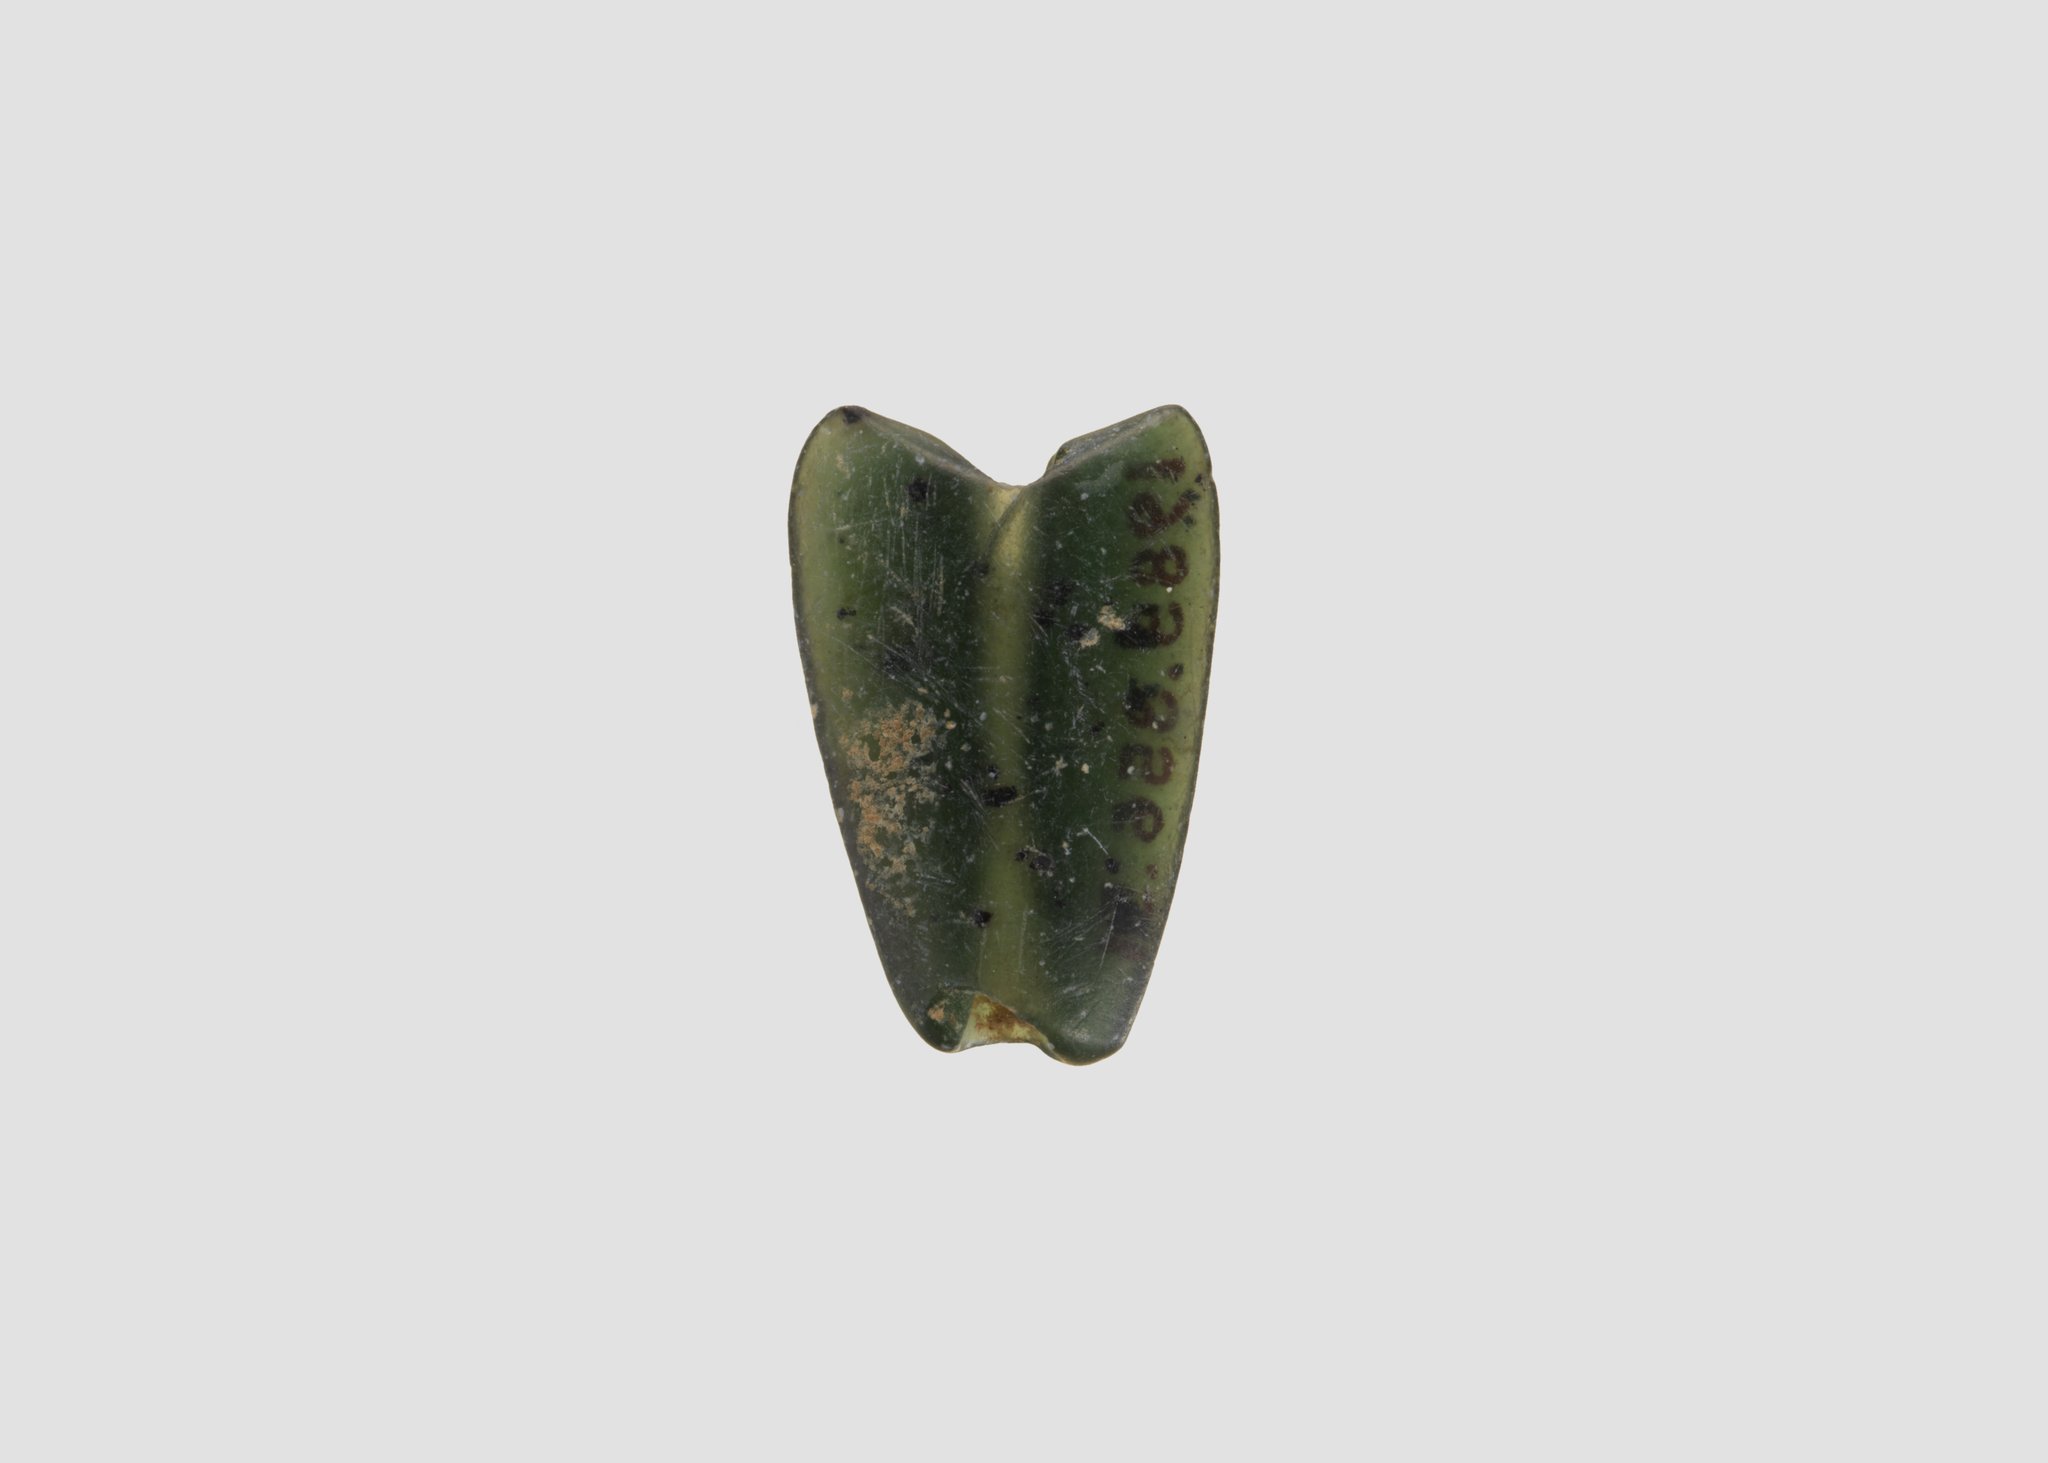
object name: bead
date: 7000-5001 BCE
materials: mineral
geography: syria